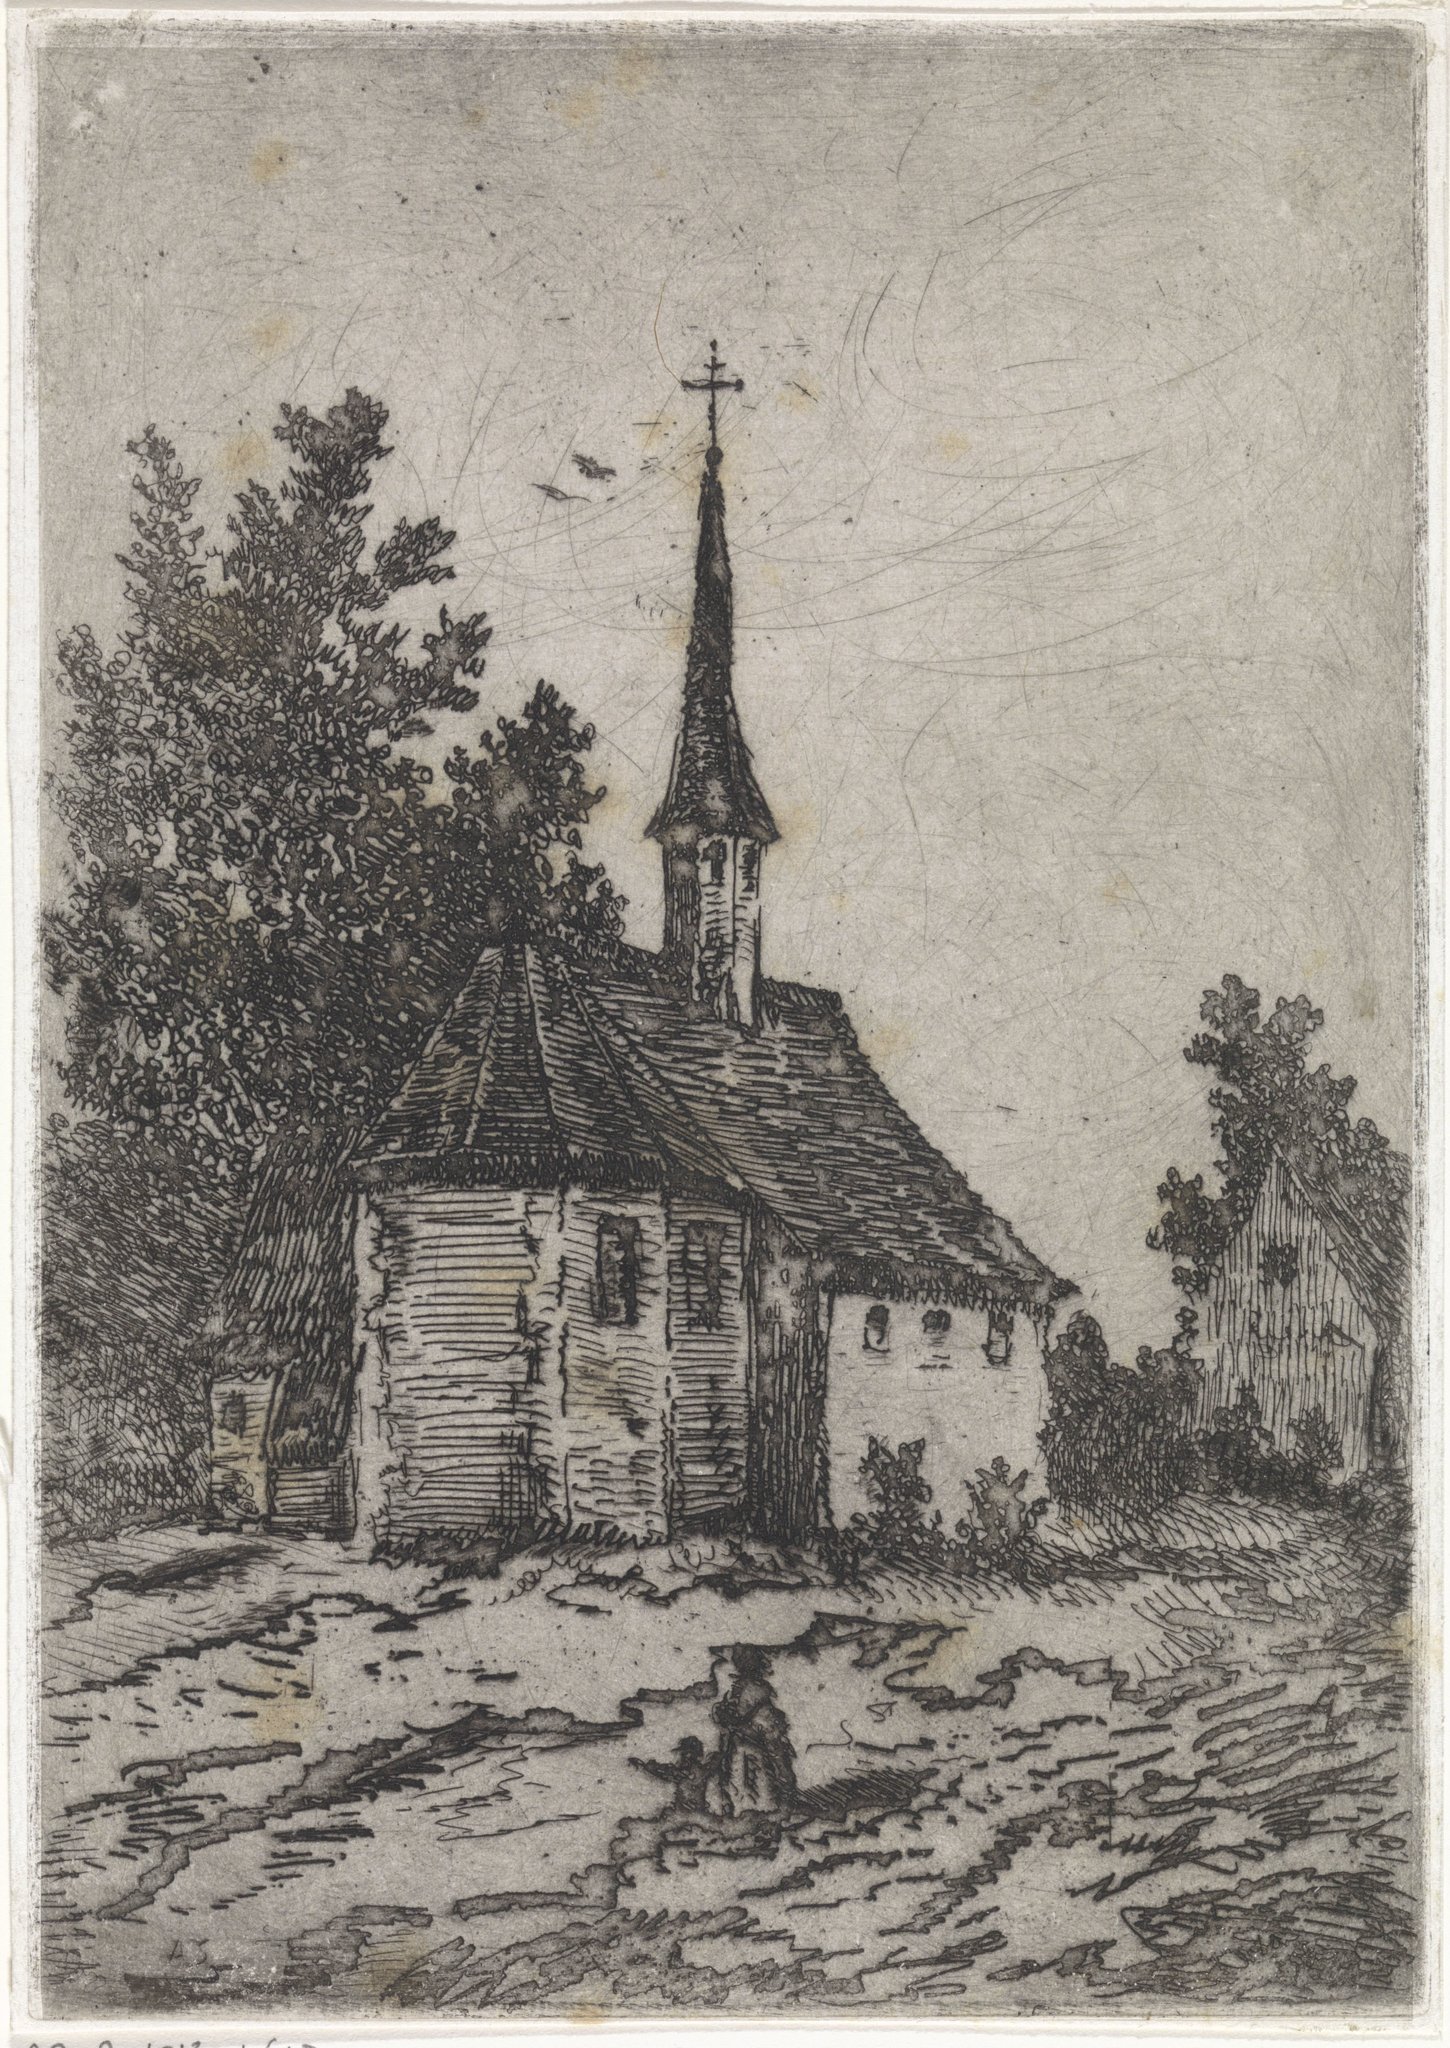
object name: print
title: Kapel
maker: arnoud schaepkens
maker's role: print maker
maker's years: 1816-1904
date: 1855-1904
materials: paper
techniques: drypoint, etching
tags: church (exterior) - qq - small church, chapel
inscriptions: collector's mark: Lugt 2228